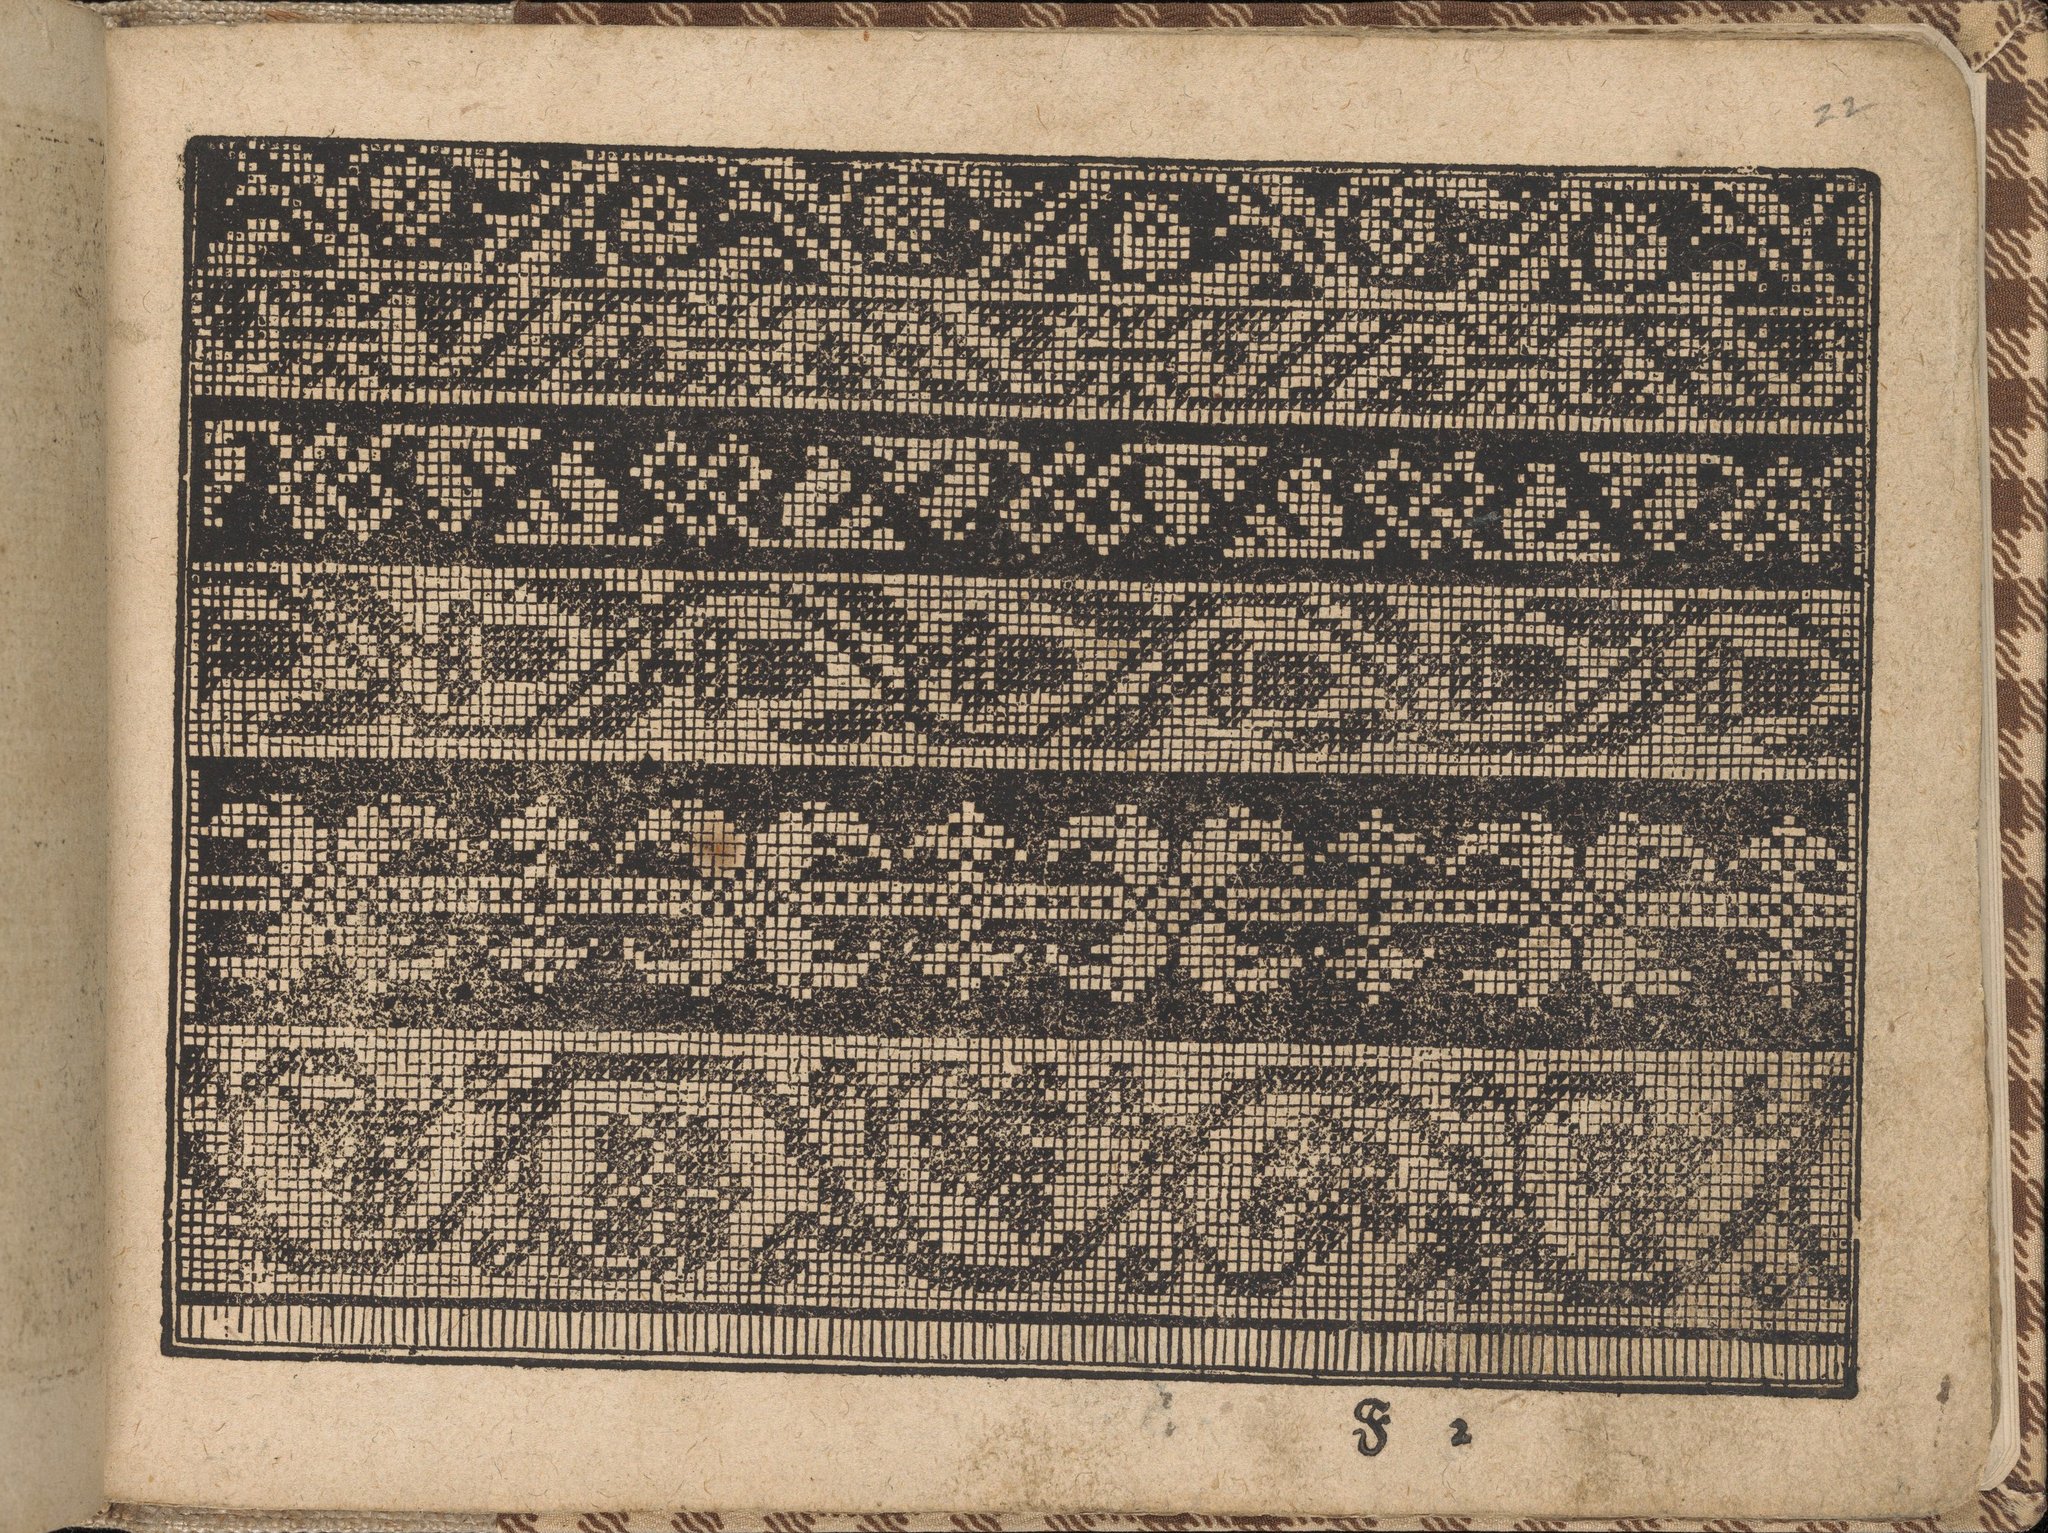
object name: book print ornament architecture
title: New Künstlichs Modelbuch (Page 22 recto)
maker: bernhard jobin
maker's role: publisher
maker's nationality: swiss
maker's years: 1535-1597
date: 1600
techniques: woodcut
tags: flowers